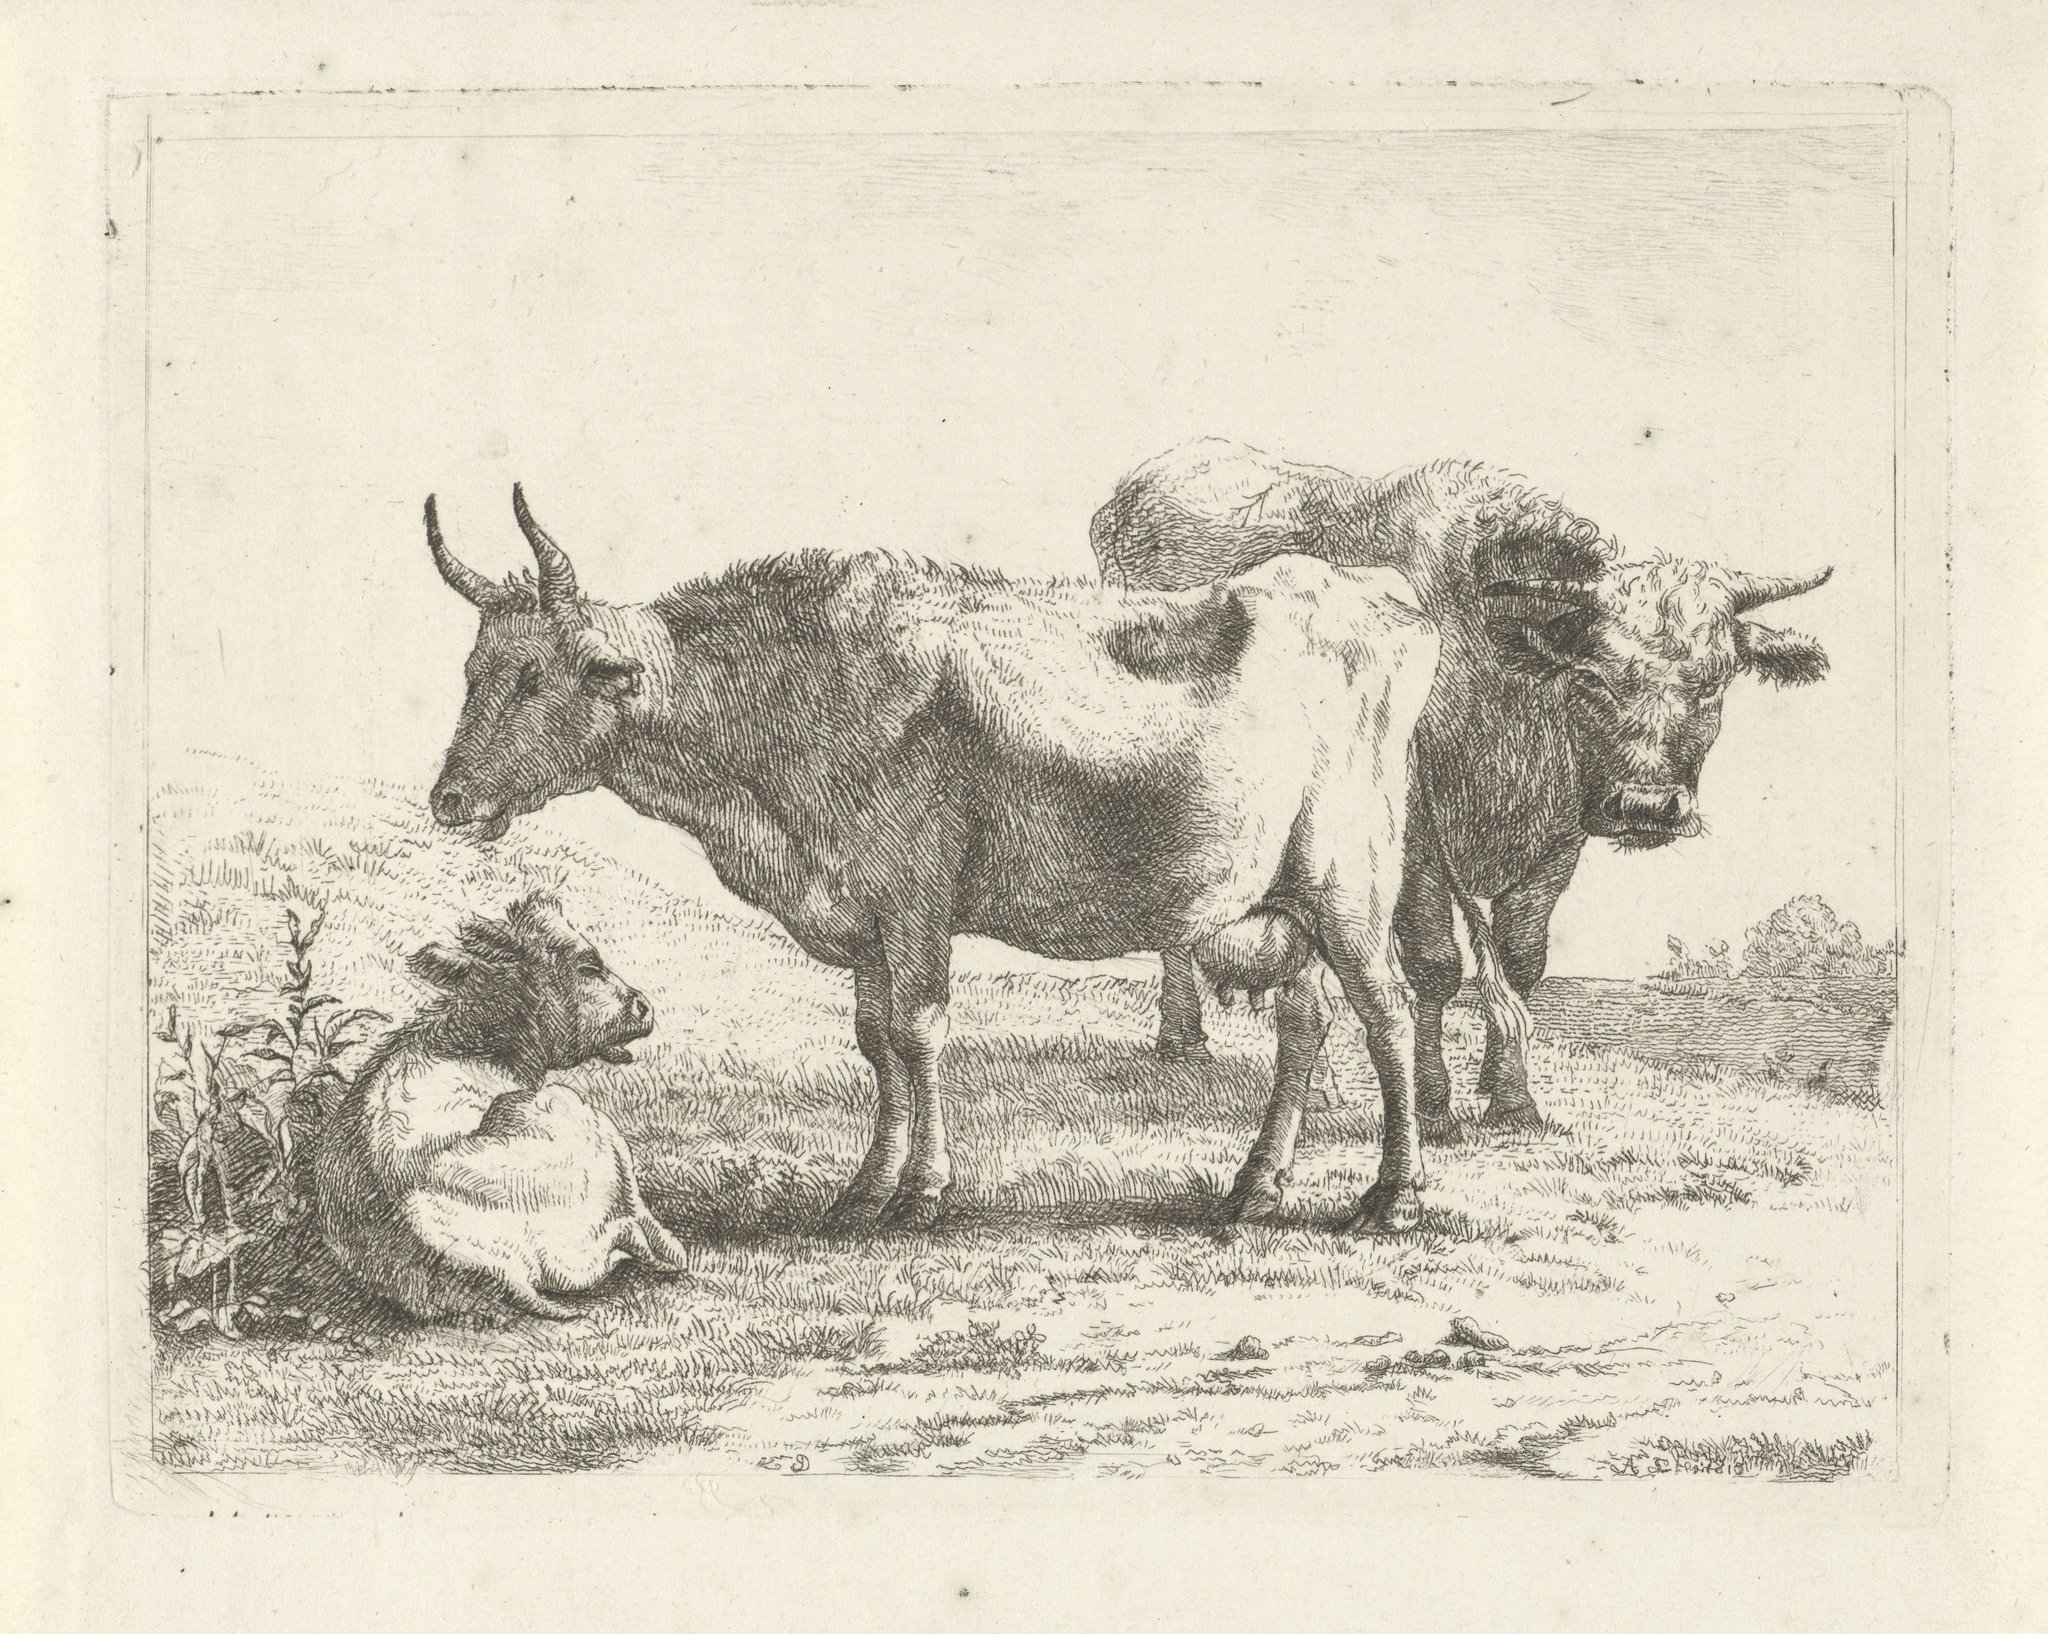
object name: print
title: Twee koeien en een kalf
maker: andries leijerdorp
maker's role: print maker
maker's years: 1789-1854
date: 1799-1854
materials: paper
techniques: etching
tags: cow, calf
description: Twee koeien en een liggend kalf in een weide.